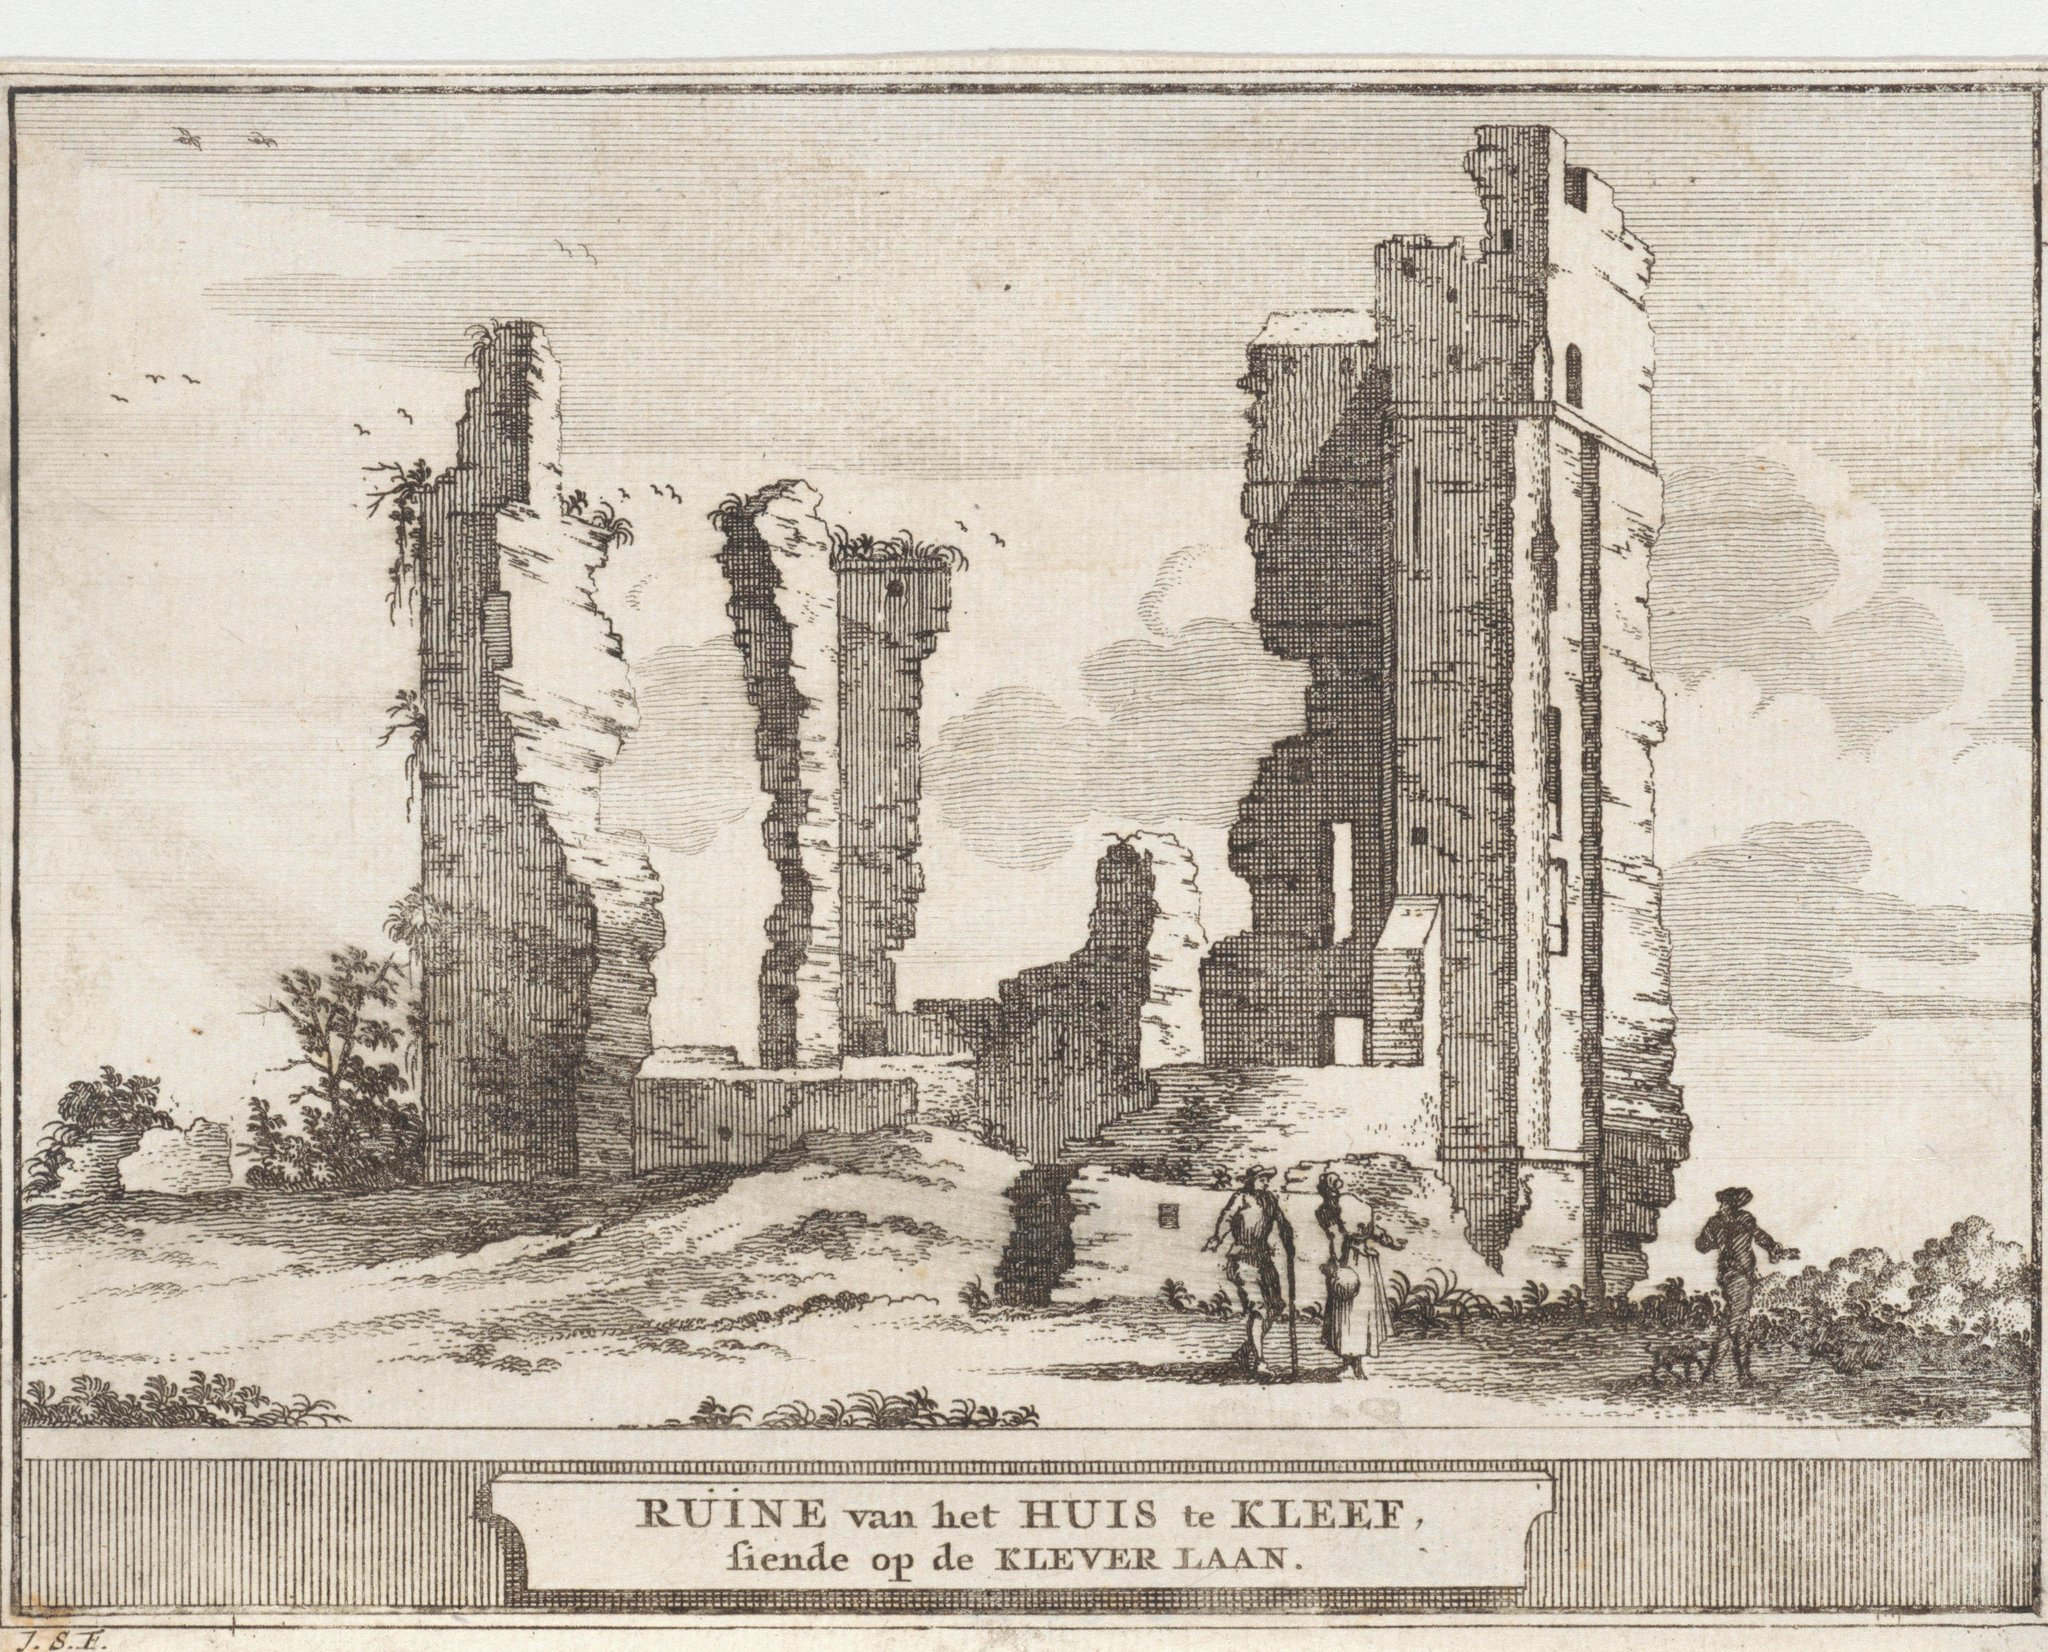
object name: print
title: Ruïne van het Huis ter Kleef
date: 1711-1774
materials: paper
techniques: etching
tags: castle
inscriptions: collector's mark: Lugt 2228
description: Prent als illustratie opgenomen in: Smids, Ludolph. Schatkamer der Nederlandsse[!] oudheden; of Woordenboek, behelsende Nederlands steden, Amsterdam: Pieter de Coup, 1711. Verscheen tevens in de heruitgave van voorgenoemd werk in 1737 en 1774. In 1721 verscheen er een uitgave met alleen de prenten: Nederlandsche oudheden, bestaande in zestig verbeeldingen (...) gelegen in Holland, 't Sticht van Utrecht en Gelderland enz. Amsterdam: Hendrik Bosch, 1721.